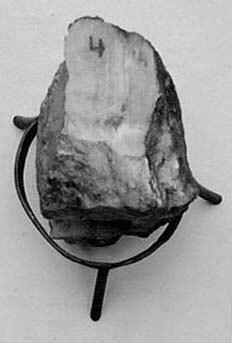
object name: fragment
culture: burmese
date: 1902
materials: jade